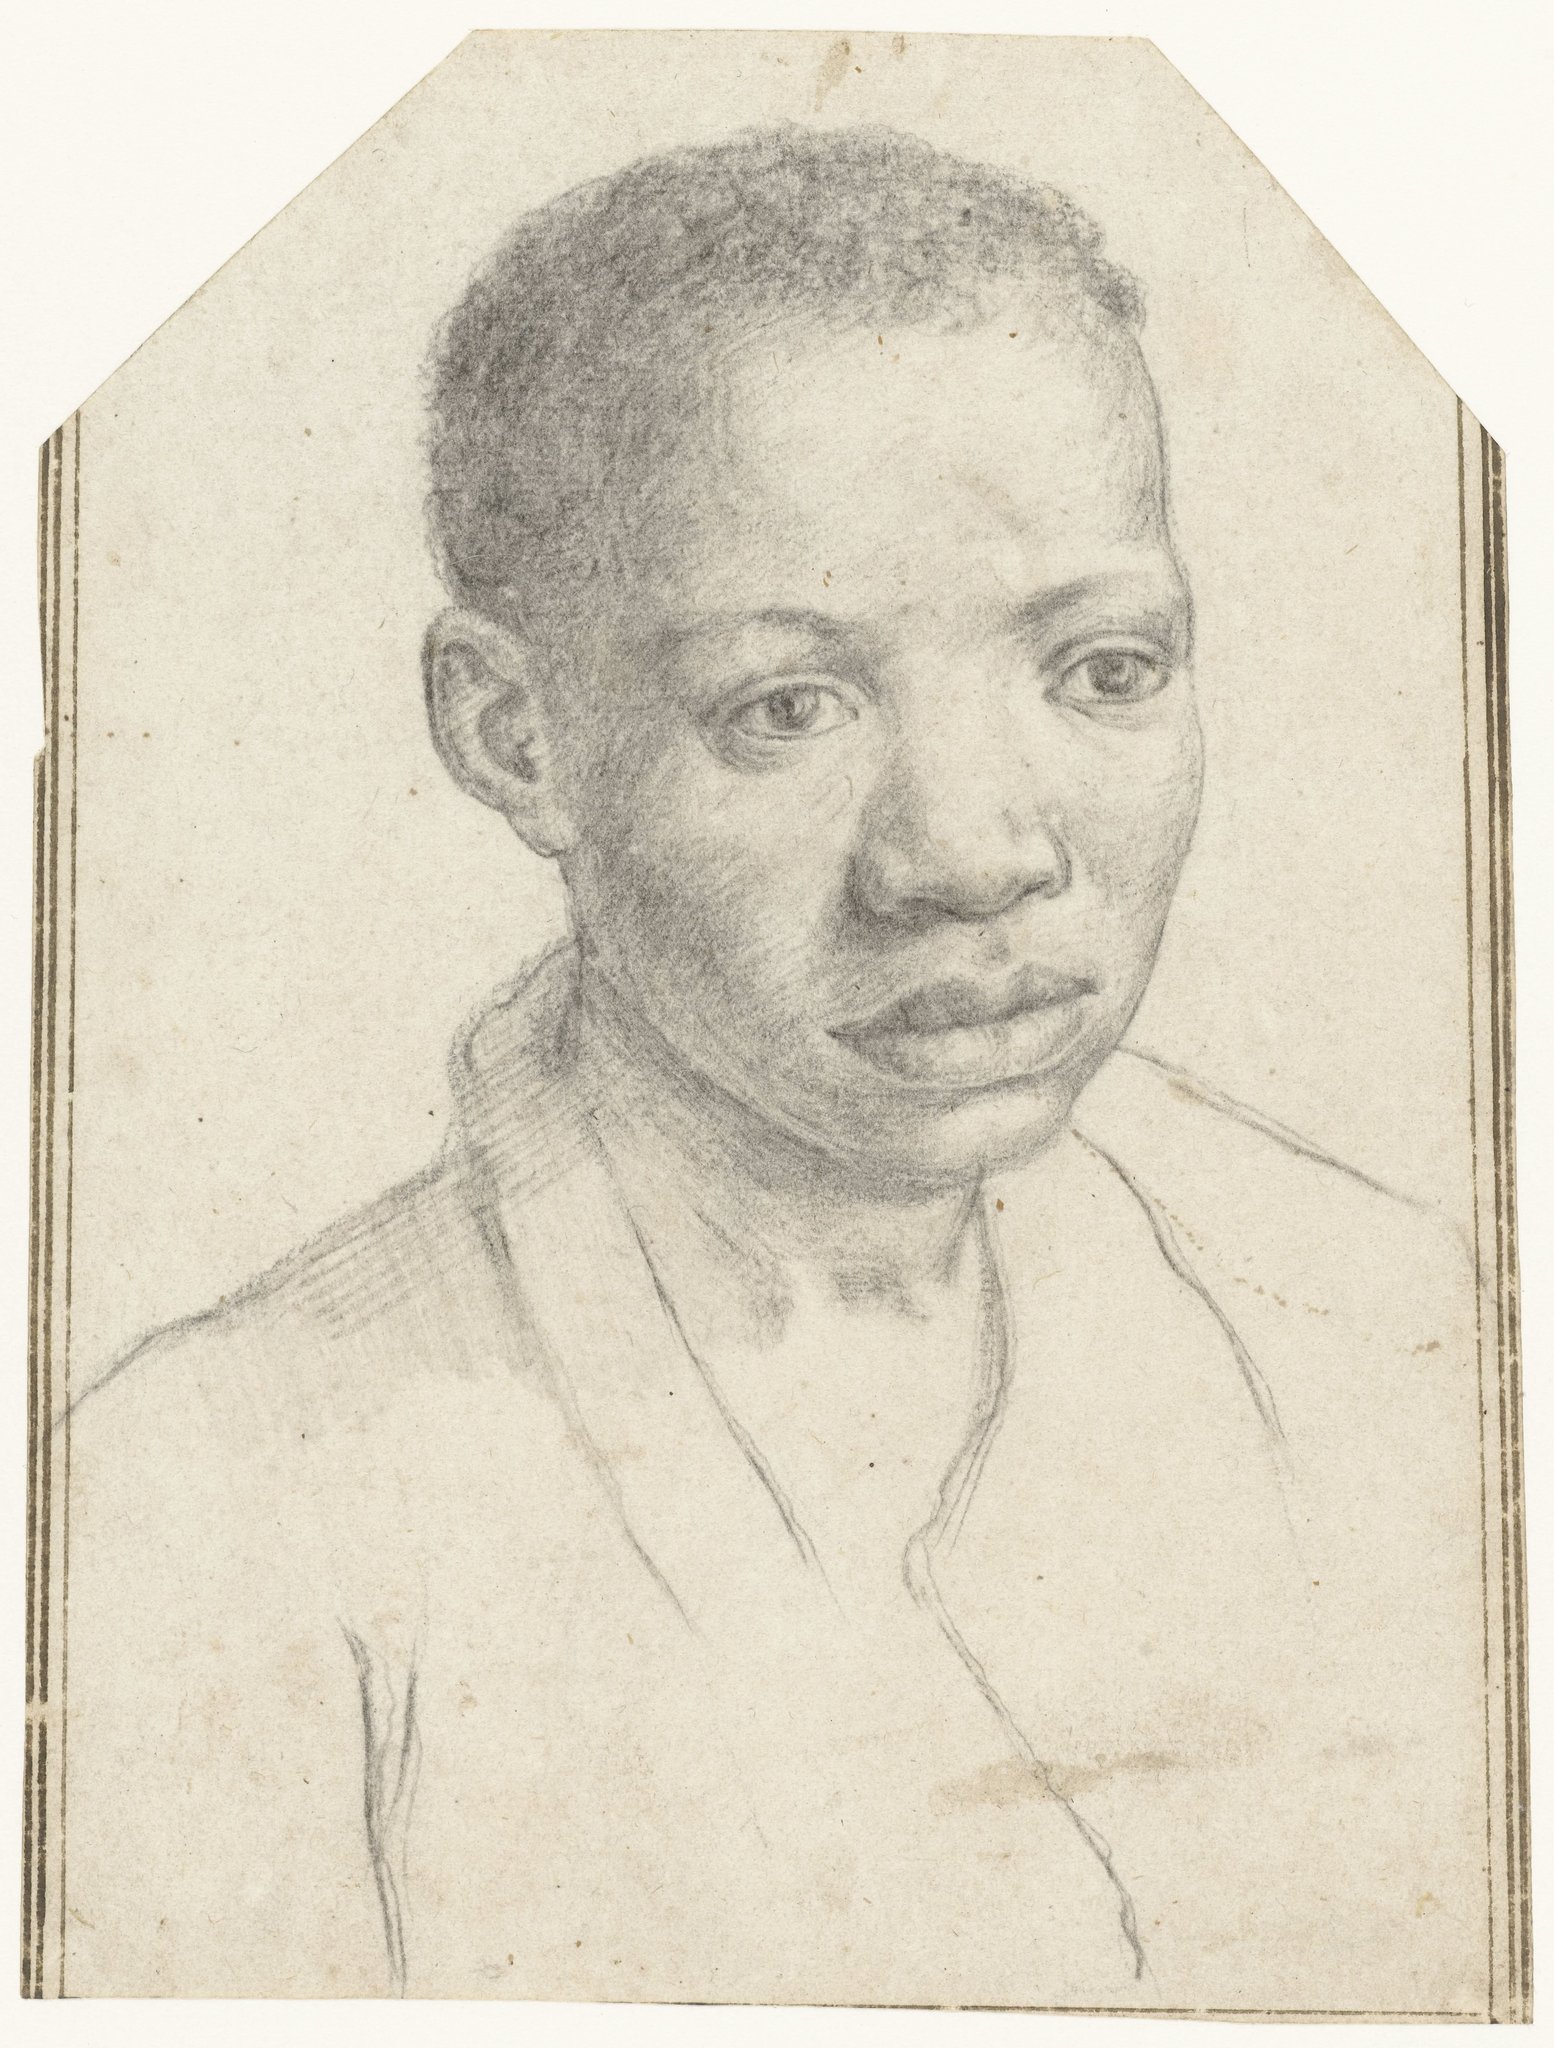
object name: drawing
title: Portret van een negerjongen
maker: antonio carracci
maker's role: draughtsman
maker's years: 1583-1618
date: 1595-1605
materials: chalk, paper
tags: africans, youth, adolescent, anonymous historical person portrayed